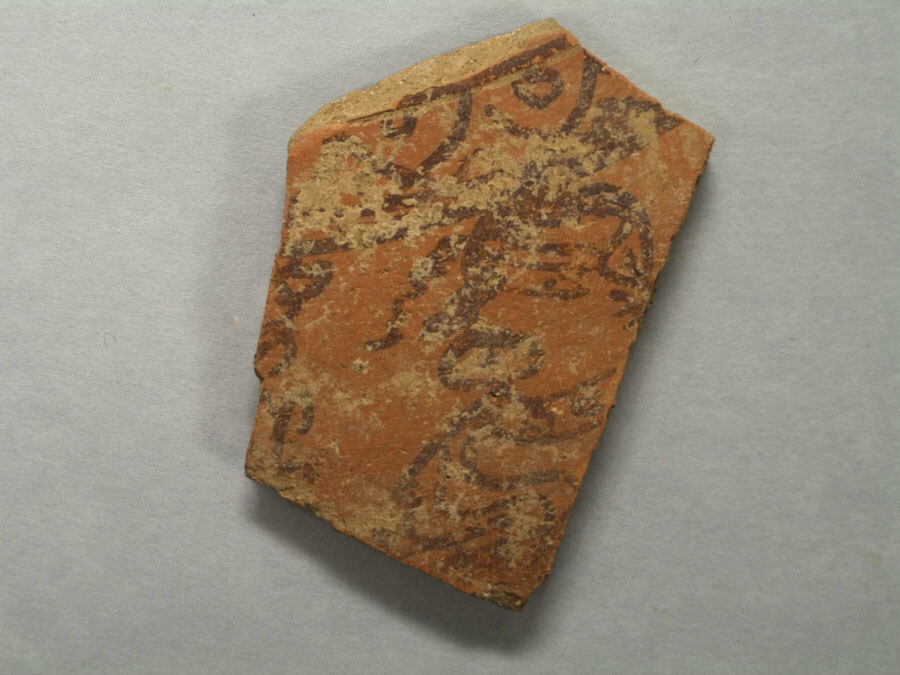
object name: shard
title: Shard: Offerer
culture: pakistani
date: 301-500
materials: terracotta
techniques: painting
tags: gandhara